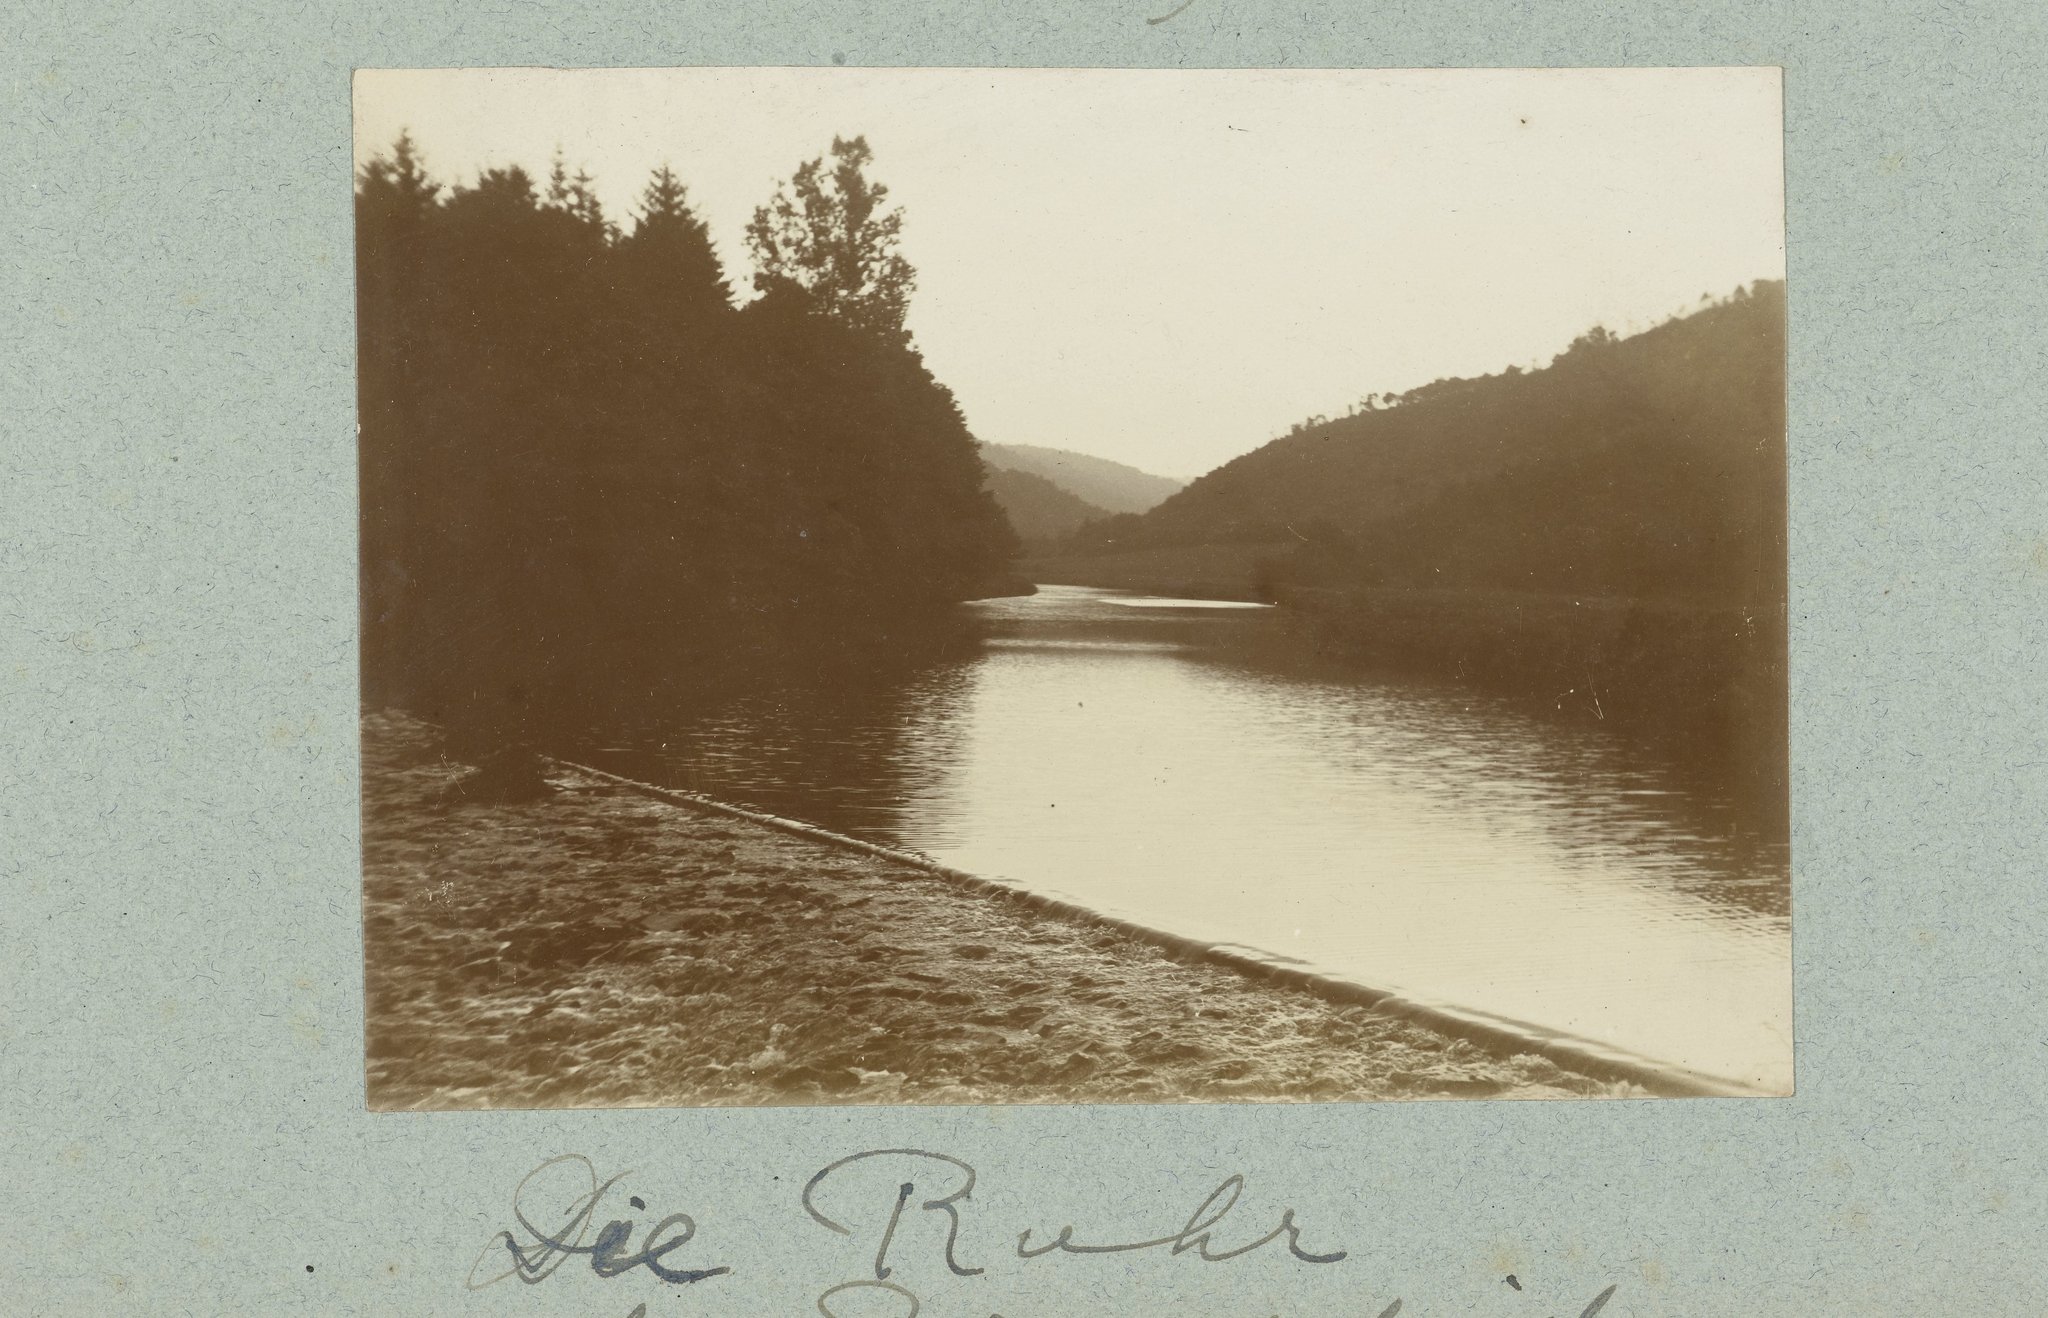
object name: photograph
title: Zicht over de rivier de Ruhr bij Remscheid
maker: frits freerks fontein fz.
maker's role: fotograaf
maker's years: 1882-1928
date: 1902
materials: cardboard, paper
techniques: gelatin silver print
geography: germany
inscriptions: caption: ‘Kaiser Wilhelm Brücke’